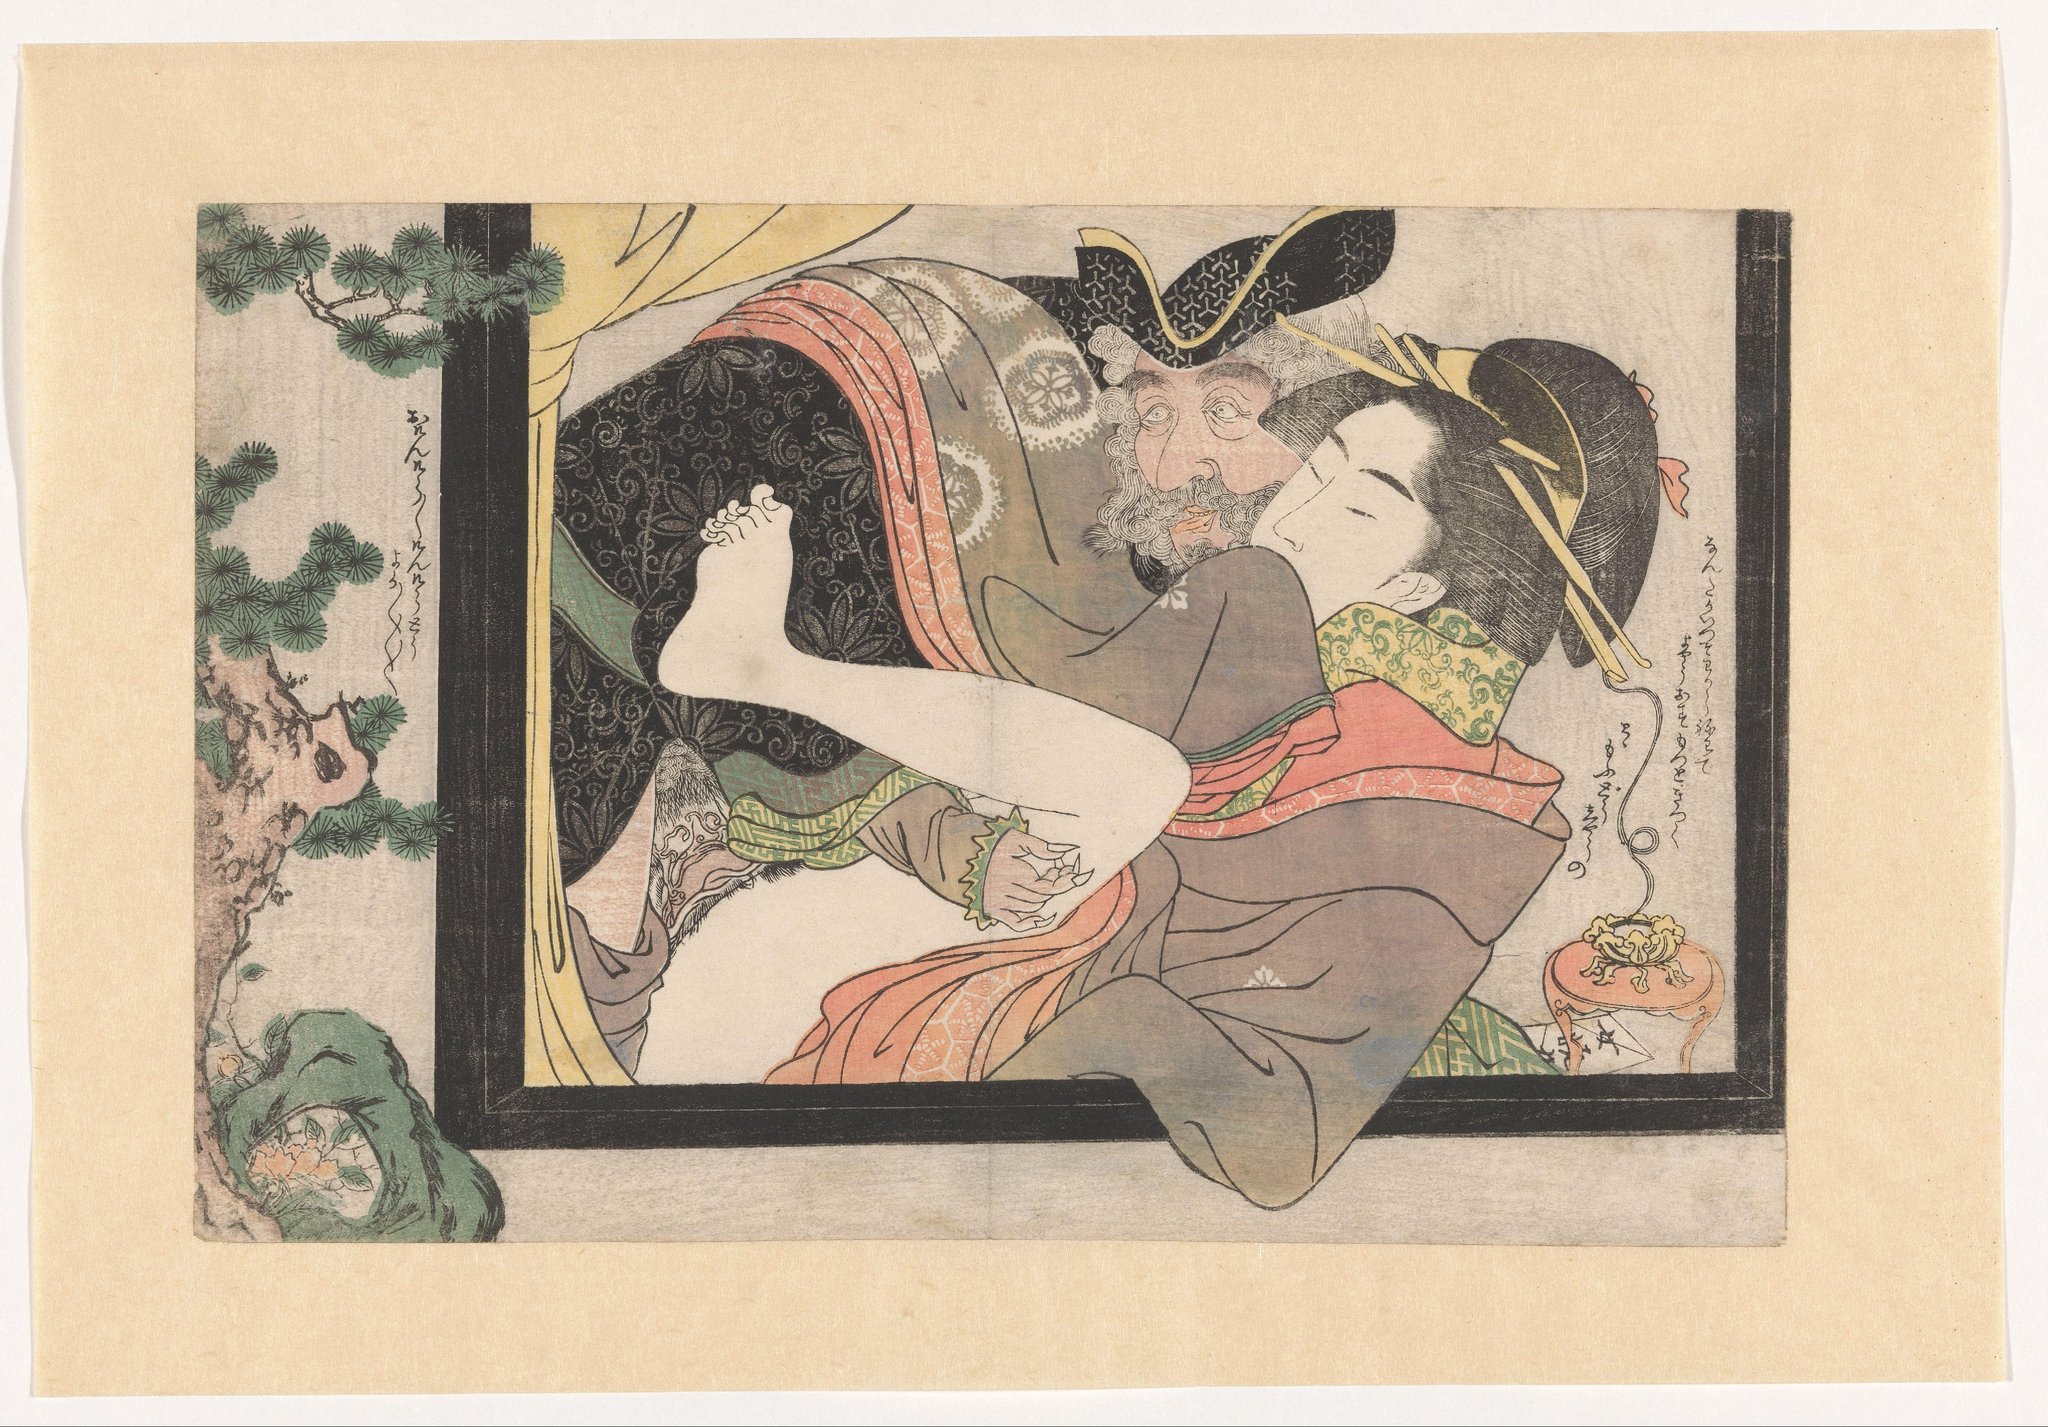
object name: shunga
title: Hollander met een Japanse courtisane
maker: chokosai eishô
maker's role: print maker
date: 1802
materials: paper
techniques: woodcut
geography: japan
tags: man and woman cohabiting, prostitution, japan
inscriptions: inscription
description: Een liggende Japanse vrouw heeft seksuele gemeenschap met een Hollandse man, ca. 1800. De kimono van de vrouw laat het onderlichaam en het linkerbeen onbedekt. De man draagt een lange mantel. Ook zijn onderlichaam is onbedekt. Hij heeft lange, puntige vingernagels. Zijn gezicht is in driekwart profiel naar links gewend en hij steekt zijn tong uit. Op het hoofd draagt hij een driekantige steek. Hij heeft halflang, krullend hoofd- en baardhaar en zware wenkbrauwen. Links tegen de kaderrand is een gordijn geschoven. Rechts is een klein tafeltje met een wierookvat afgebeeld. Daaronder ligt een beschreven enveloppe. Buiten de kaderrand is links een rotsachtige heuvel met naaldboom. In de opschriften details over de gemeenschap.